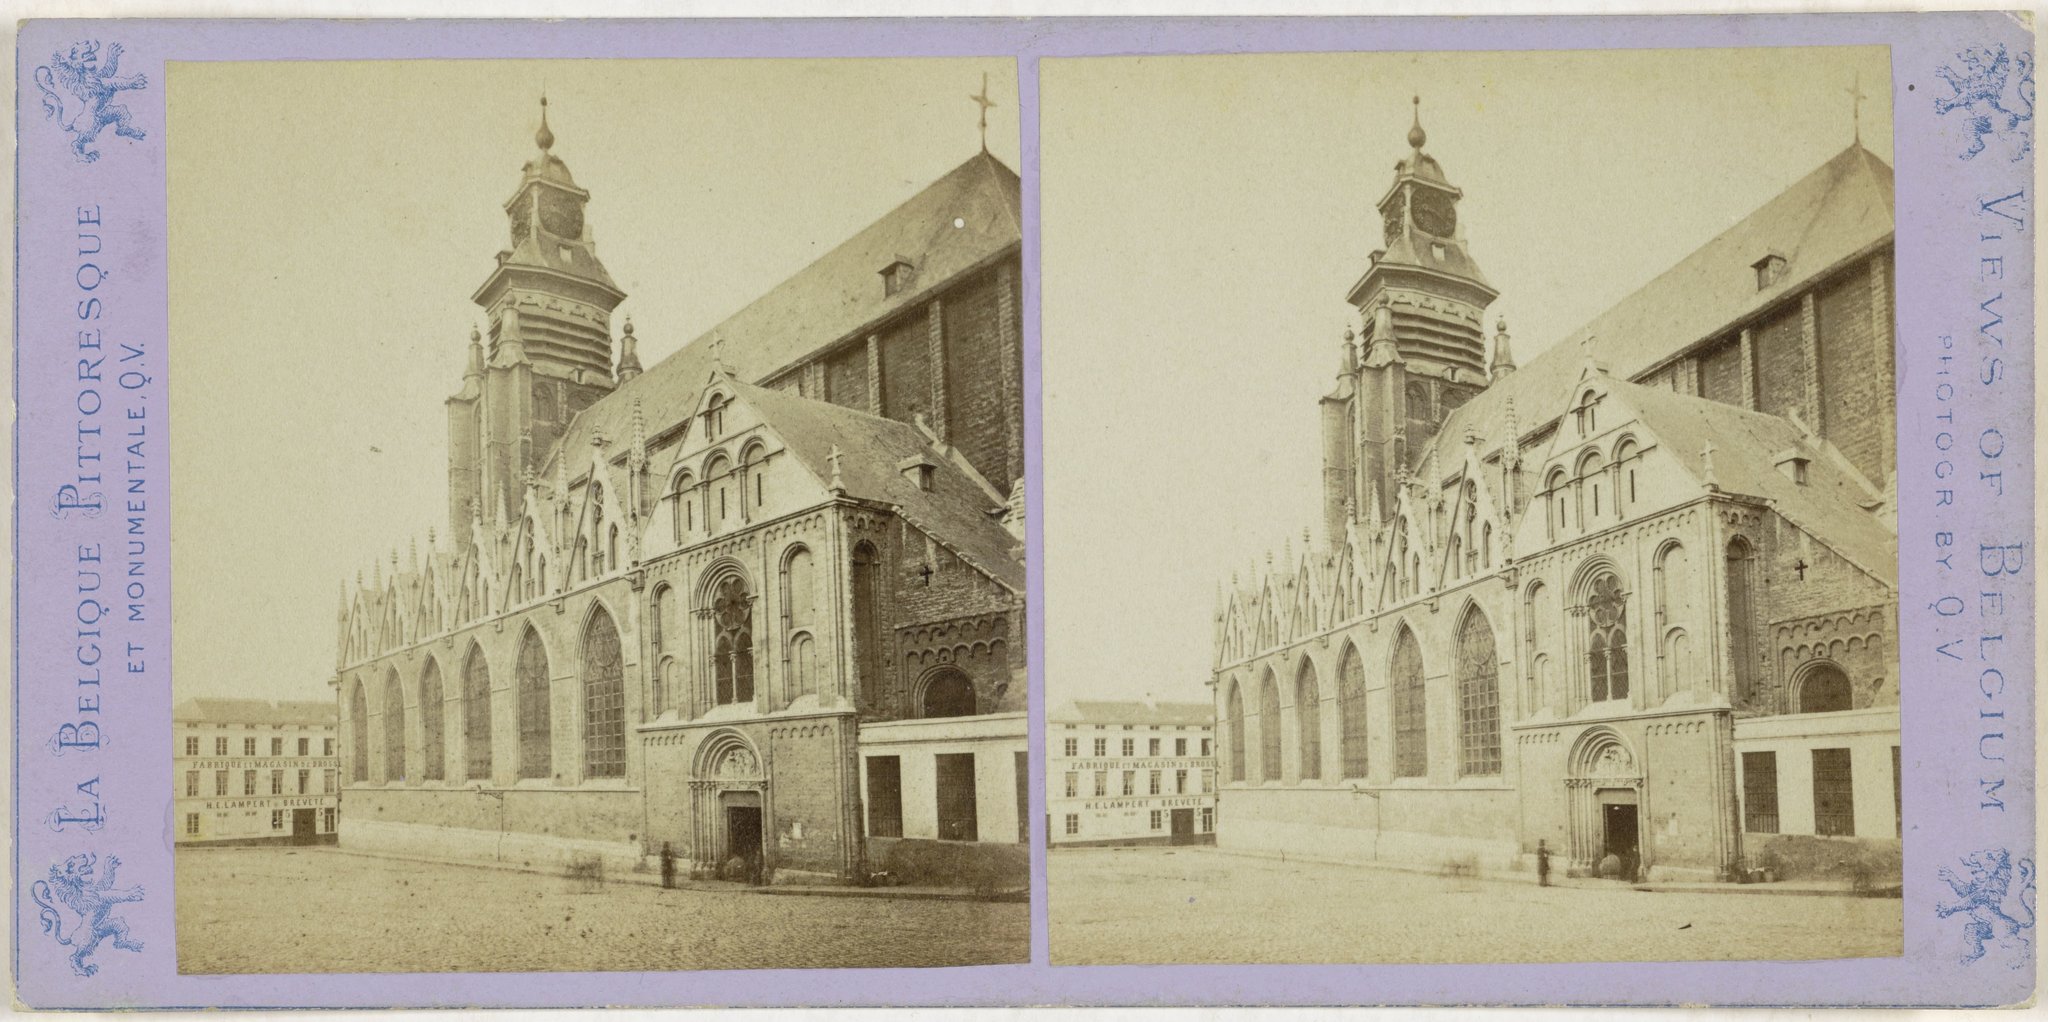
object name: stereograph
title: La Belgique pittoresque et monumentale / Views of Belgium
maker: jules hippolyte quéval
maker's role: publisher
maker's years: 1824-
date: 1866-1870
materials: cardboard, paper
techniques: albumen print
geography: brussels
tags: parts of church exterior and annexes - qq - small church, chapel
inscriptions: number: ‘No 1608’